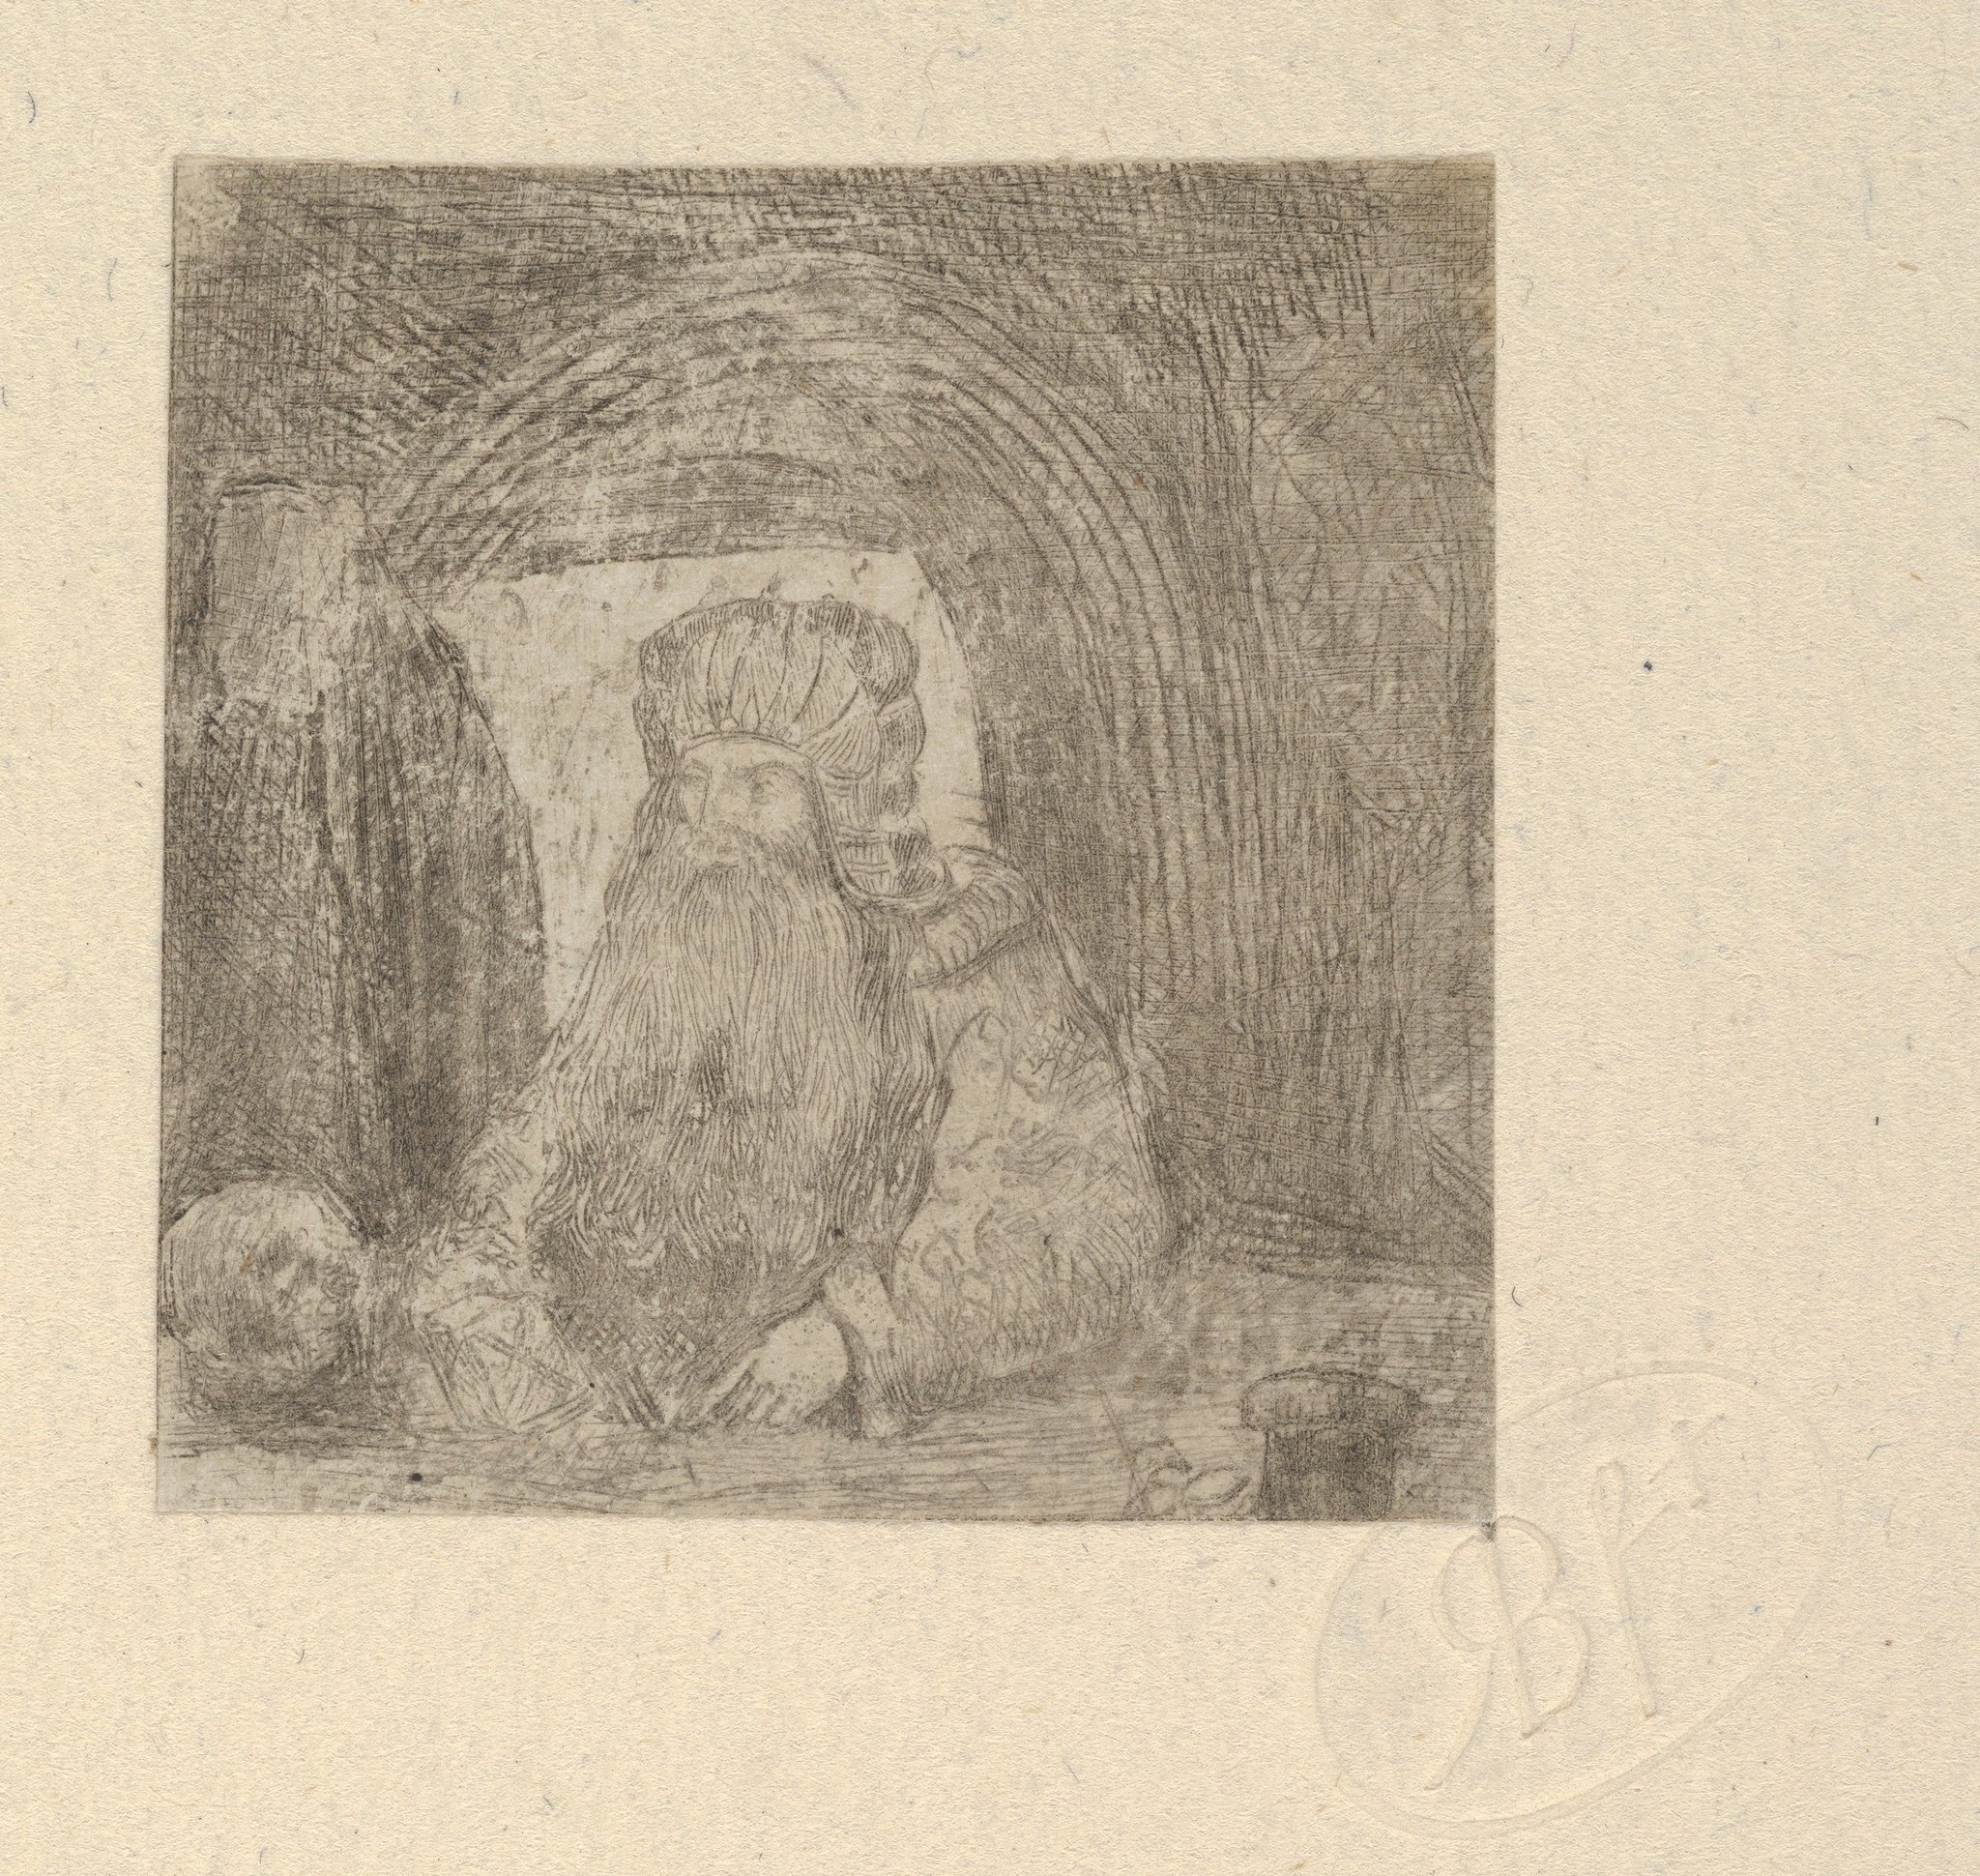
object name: print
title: L'Ermite à la Tête de Mort (The Hermit with Skull)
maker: rodolphe bresdin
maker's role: artist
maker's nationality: french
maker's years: 1822-1885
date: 1801-1900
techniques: etching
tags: skulls,men,portraits